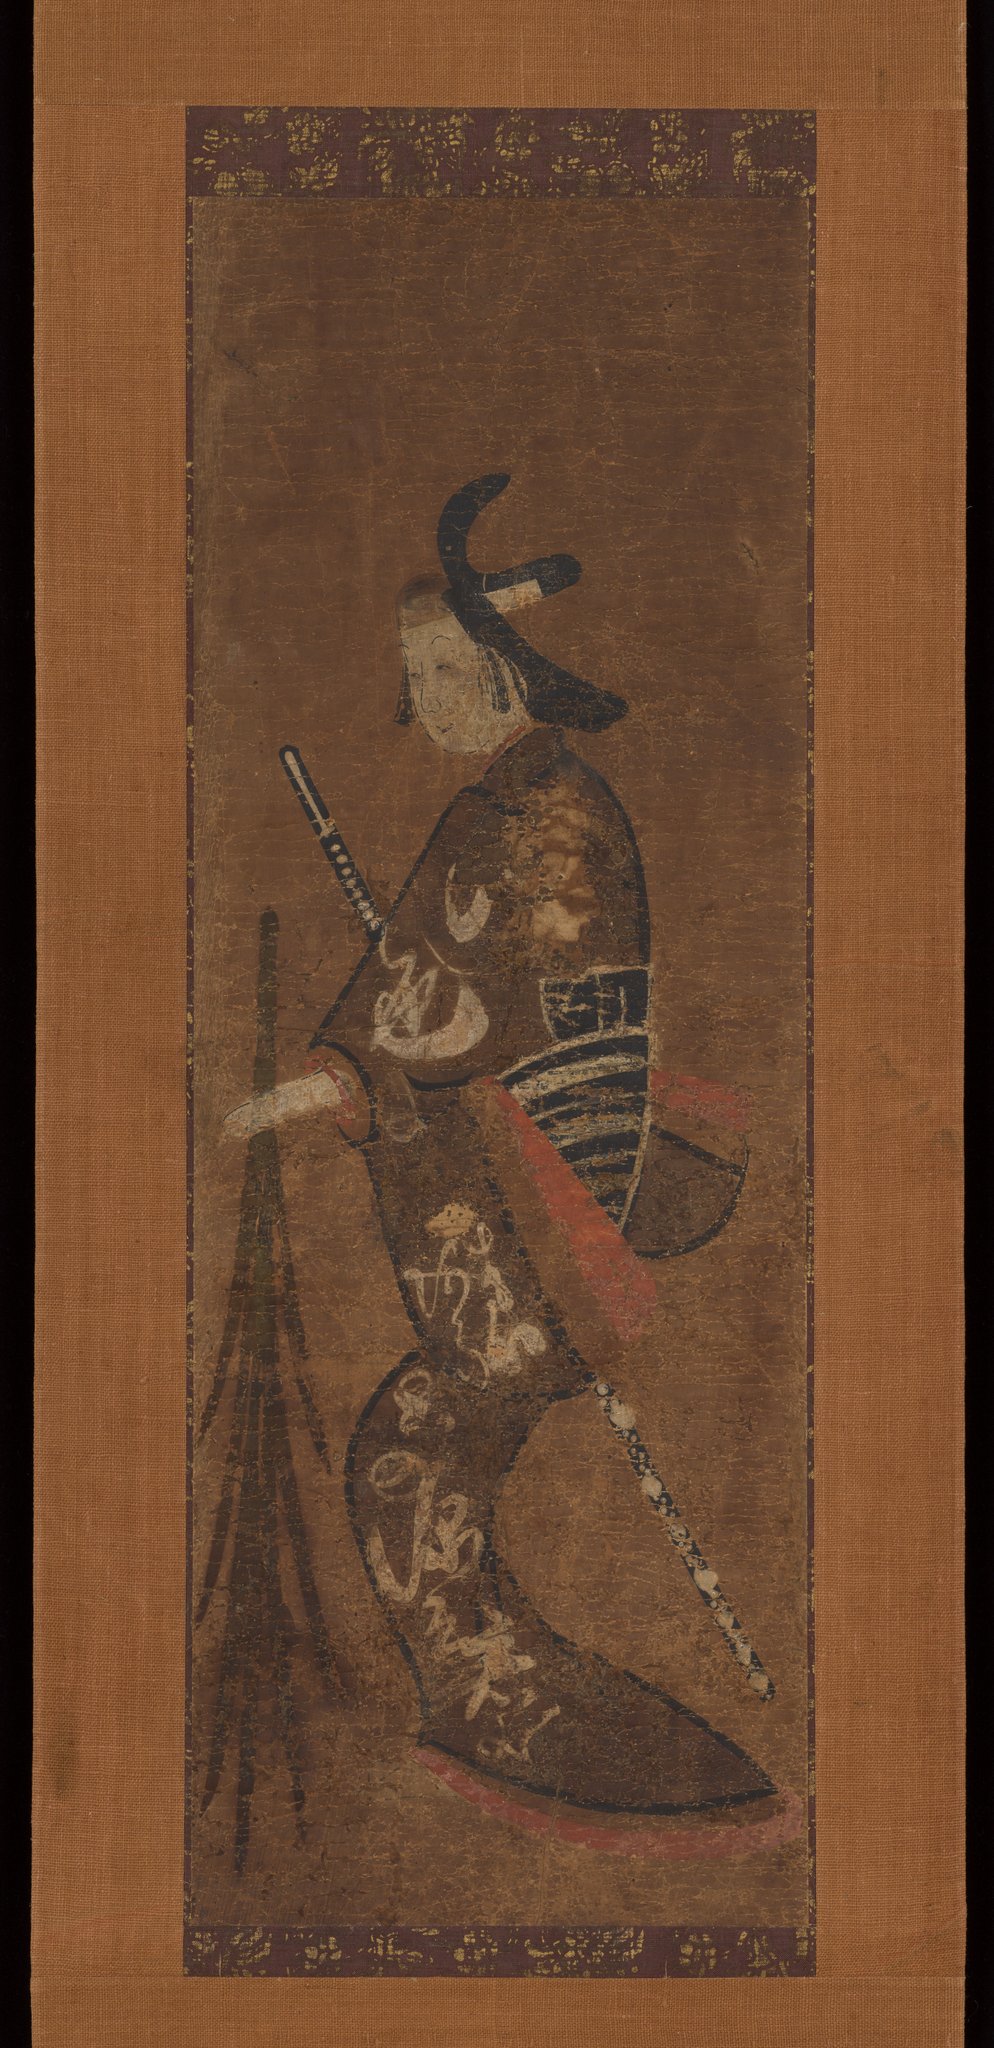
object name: hanging scroll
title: Ōtsu-e of a Youth Holding Irises (Yarō)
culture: japanese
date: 1601-1700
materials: ink, paper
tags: men